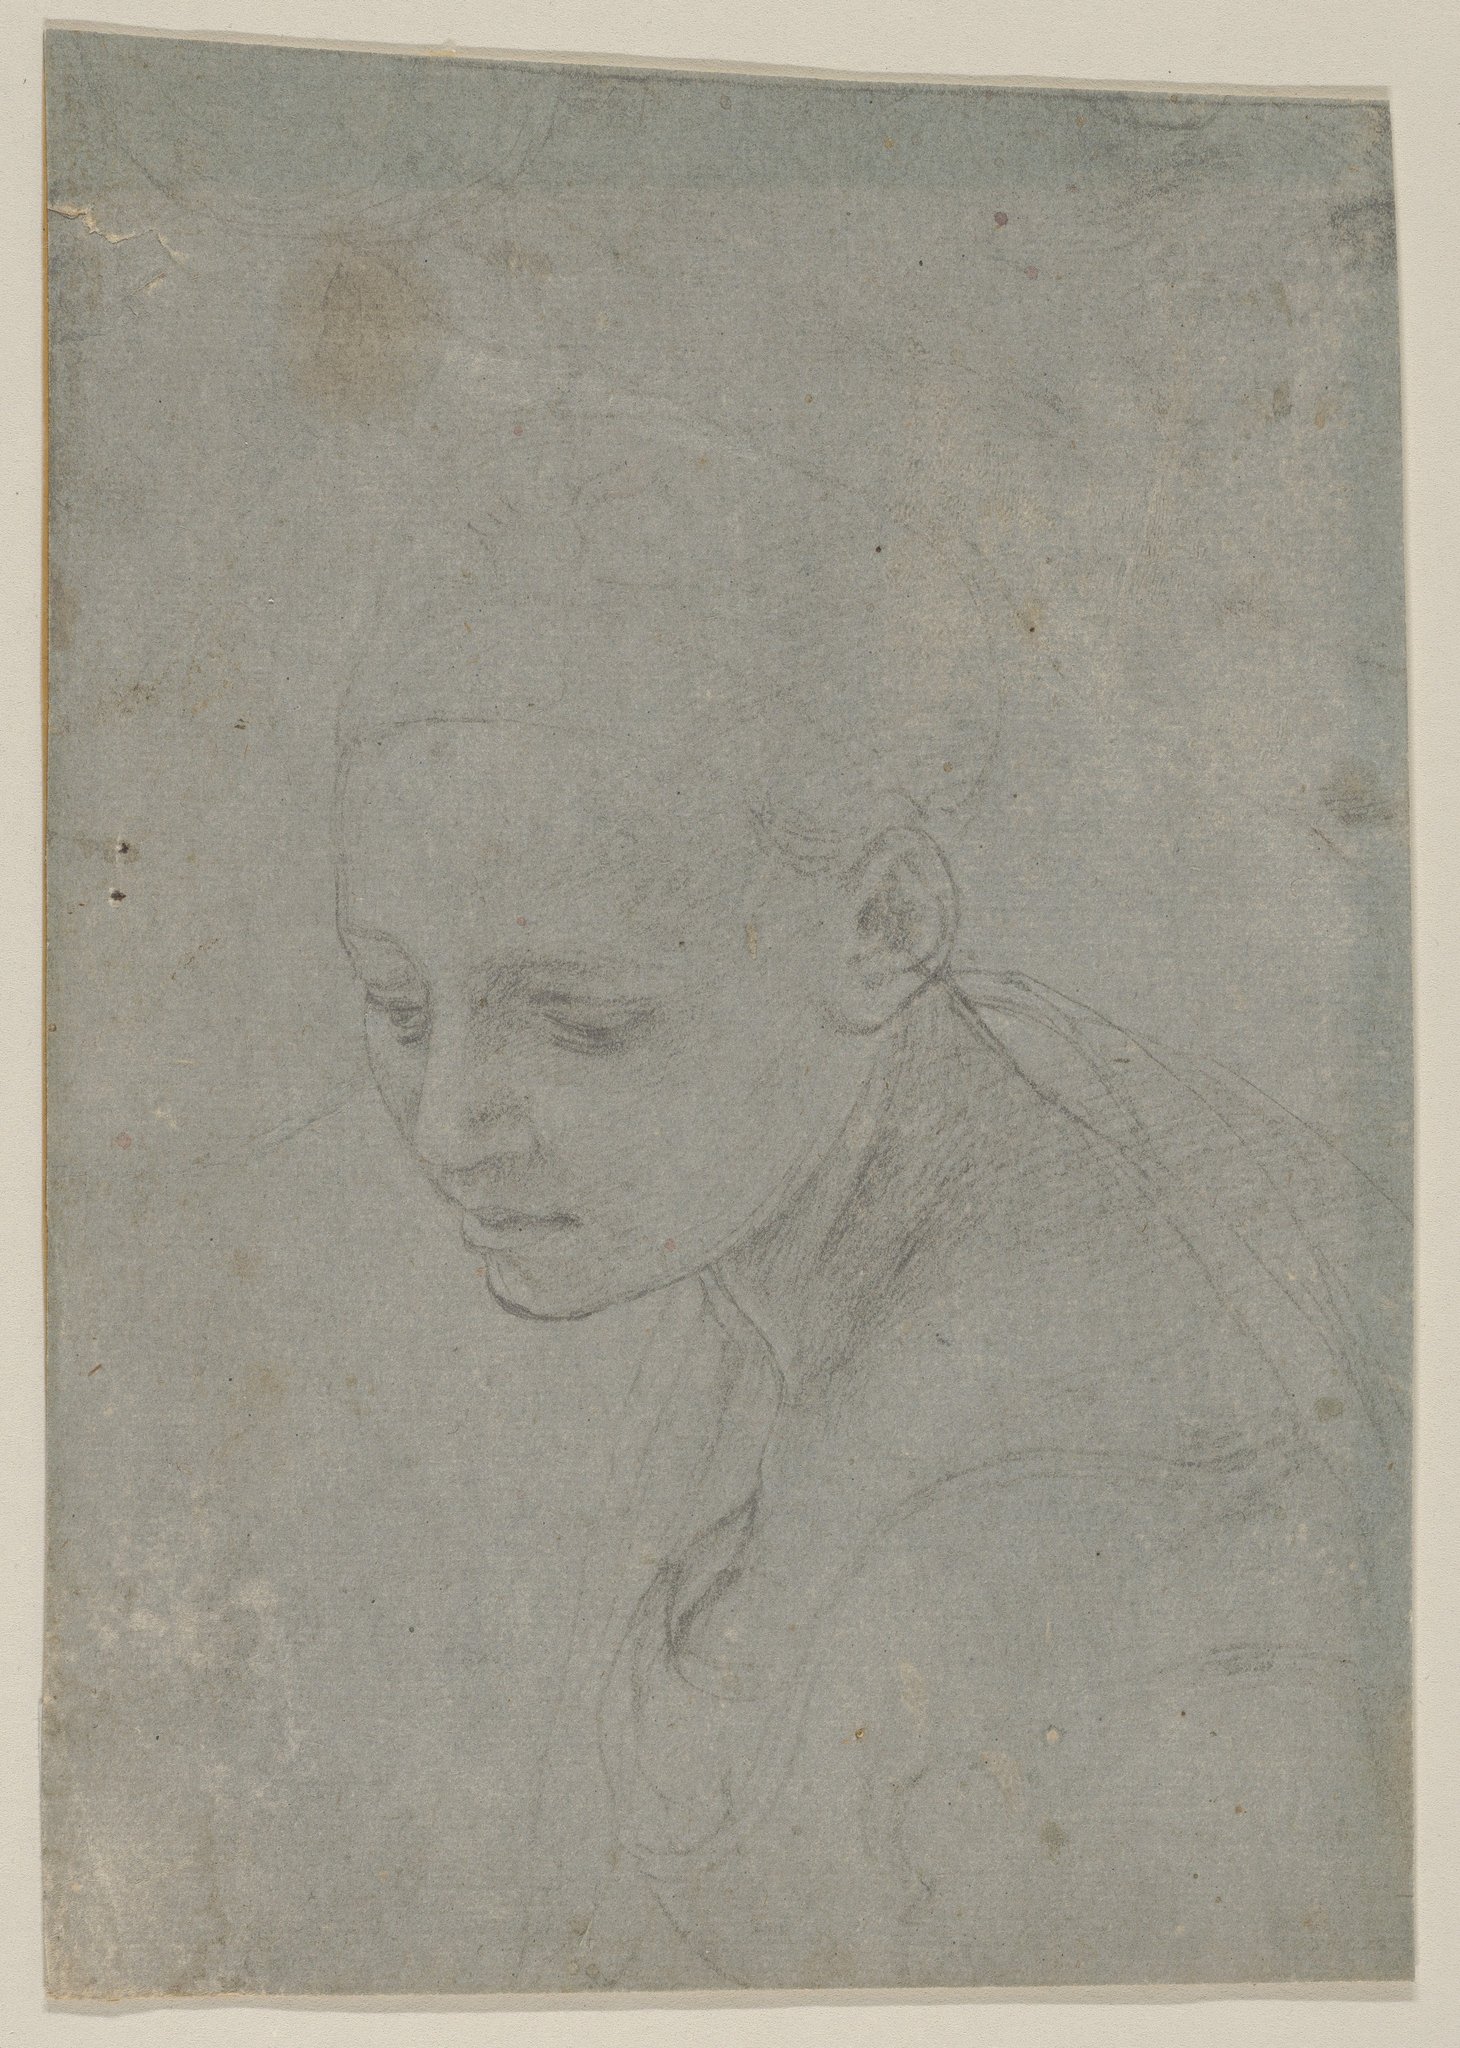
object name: drawing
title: Study of a Young Woman in Three-quarter Bust-Length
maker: bronzino (agnolo di cosimo di mariano)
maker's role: artist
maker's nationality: italian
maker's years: 1503-1572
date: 1540-1542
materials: chalk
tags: portraits,women